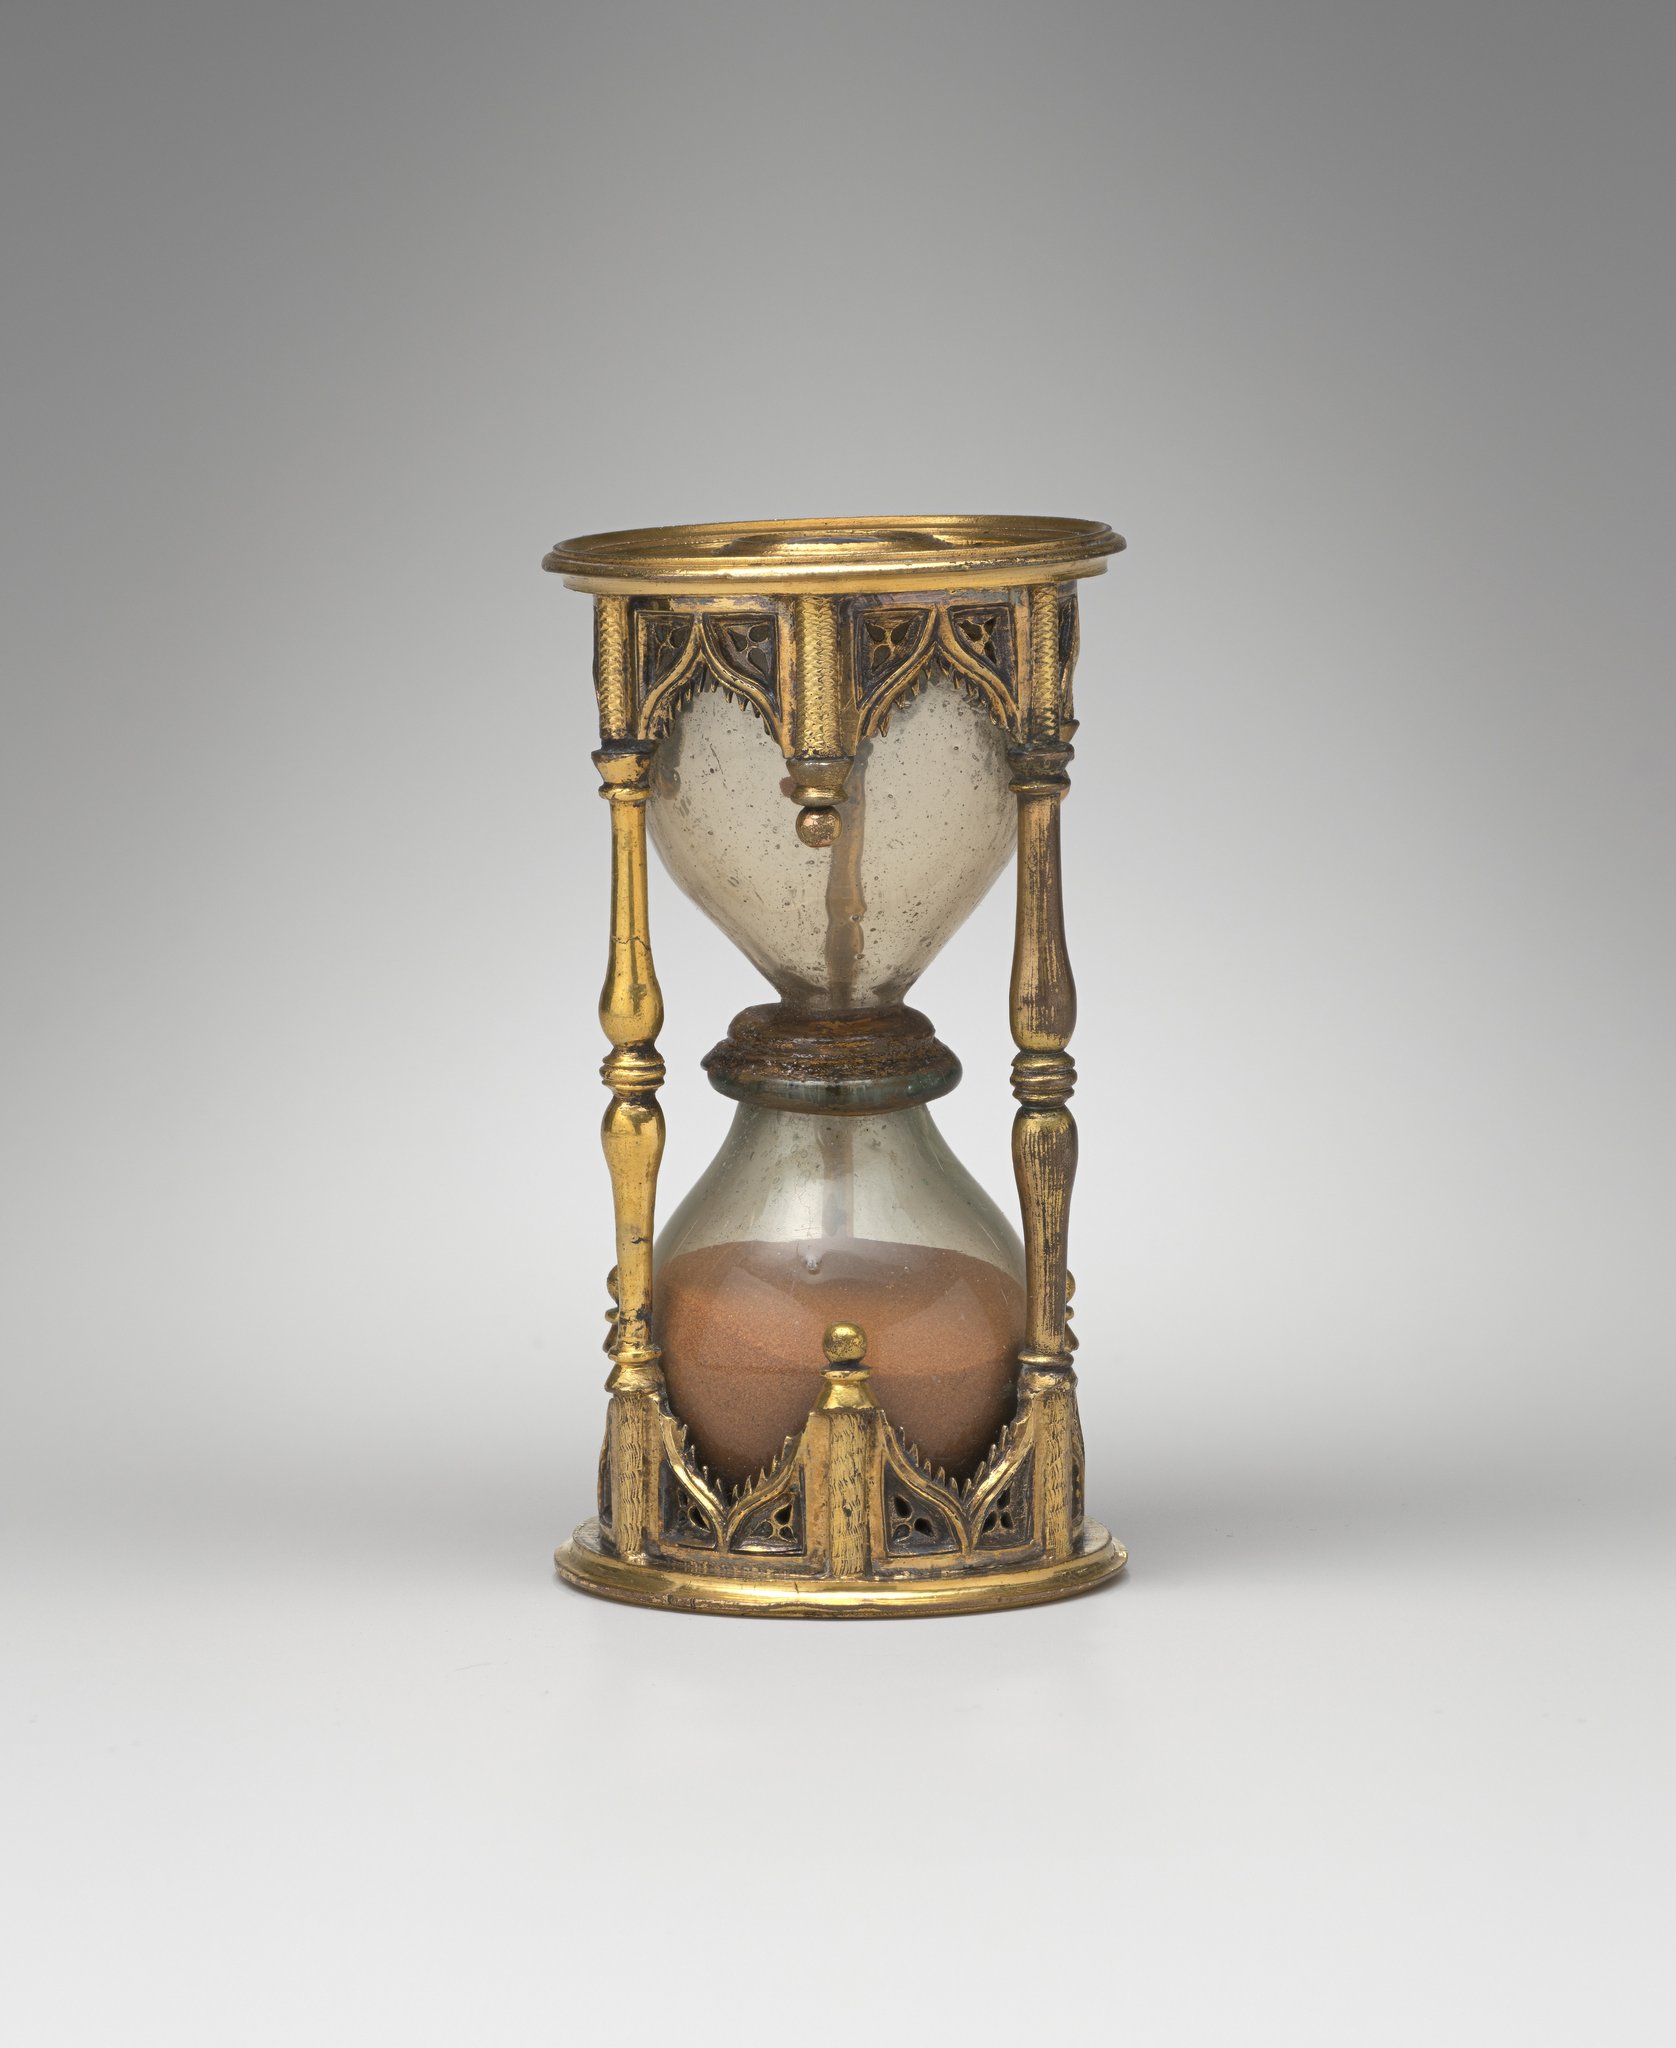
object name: half hour sandglass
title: Half-hour sandglass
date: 1500-1525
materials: bronze, gilt silver, glass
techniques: gilding